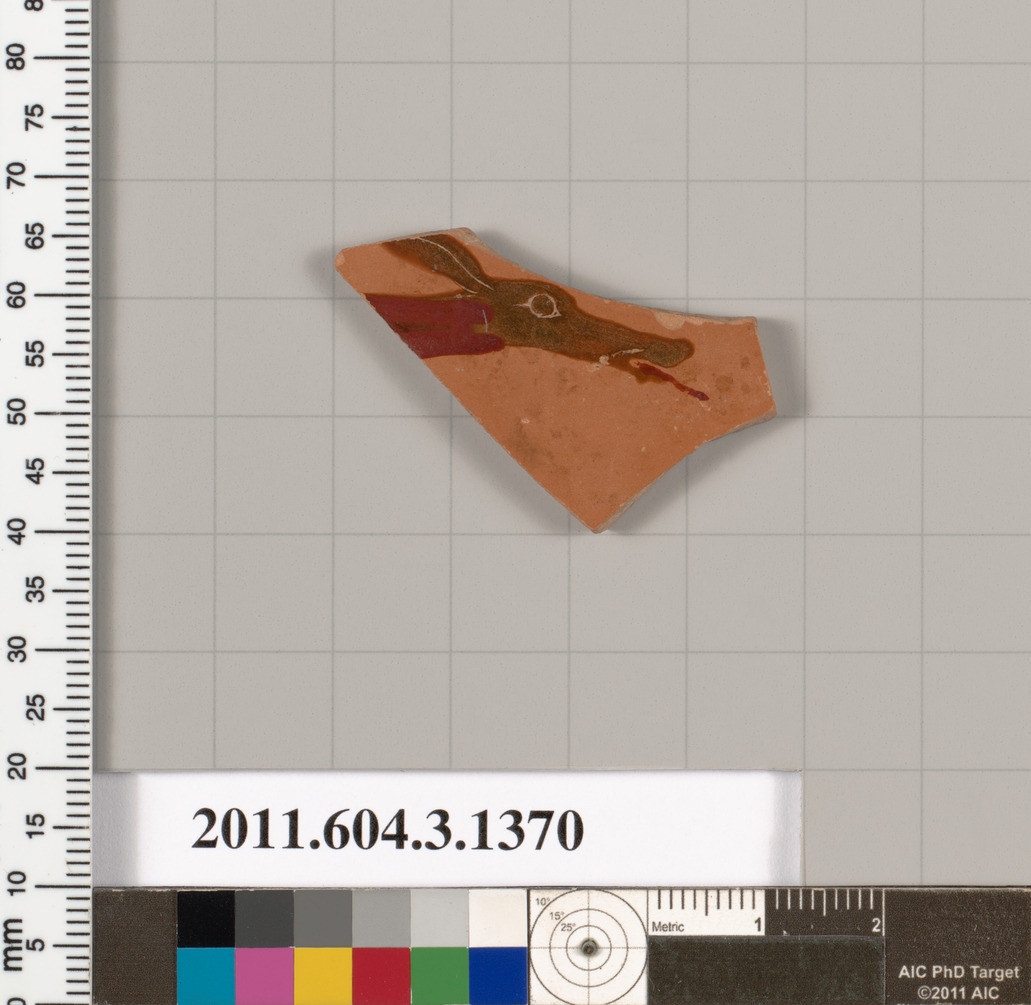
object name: skyphos fragment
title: Terracotta fragment of a skyphos (deep drinking cup)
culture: greek, attic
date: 534-468 BCE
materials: terracotta